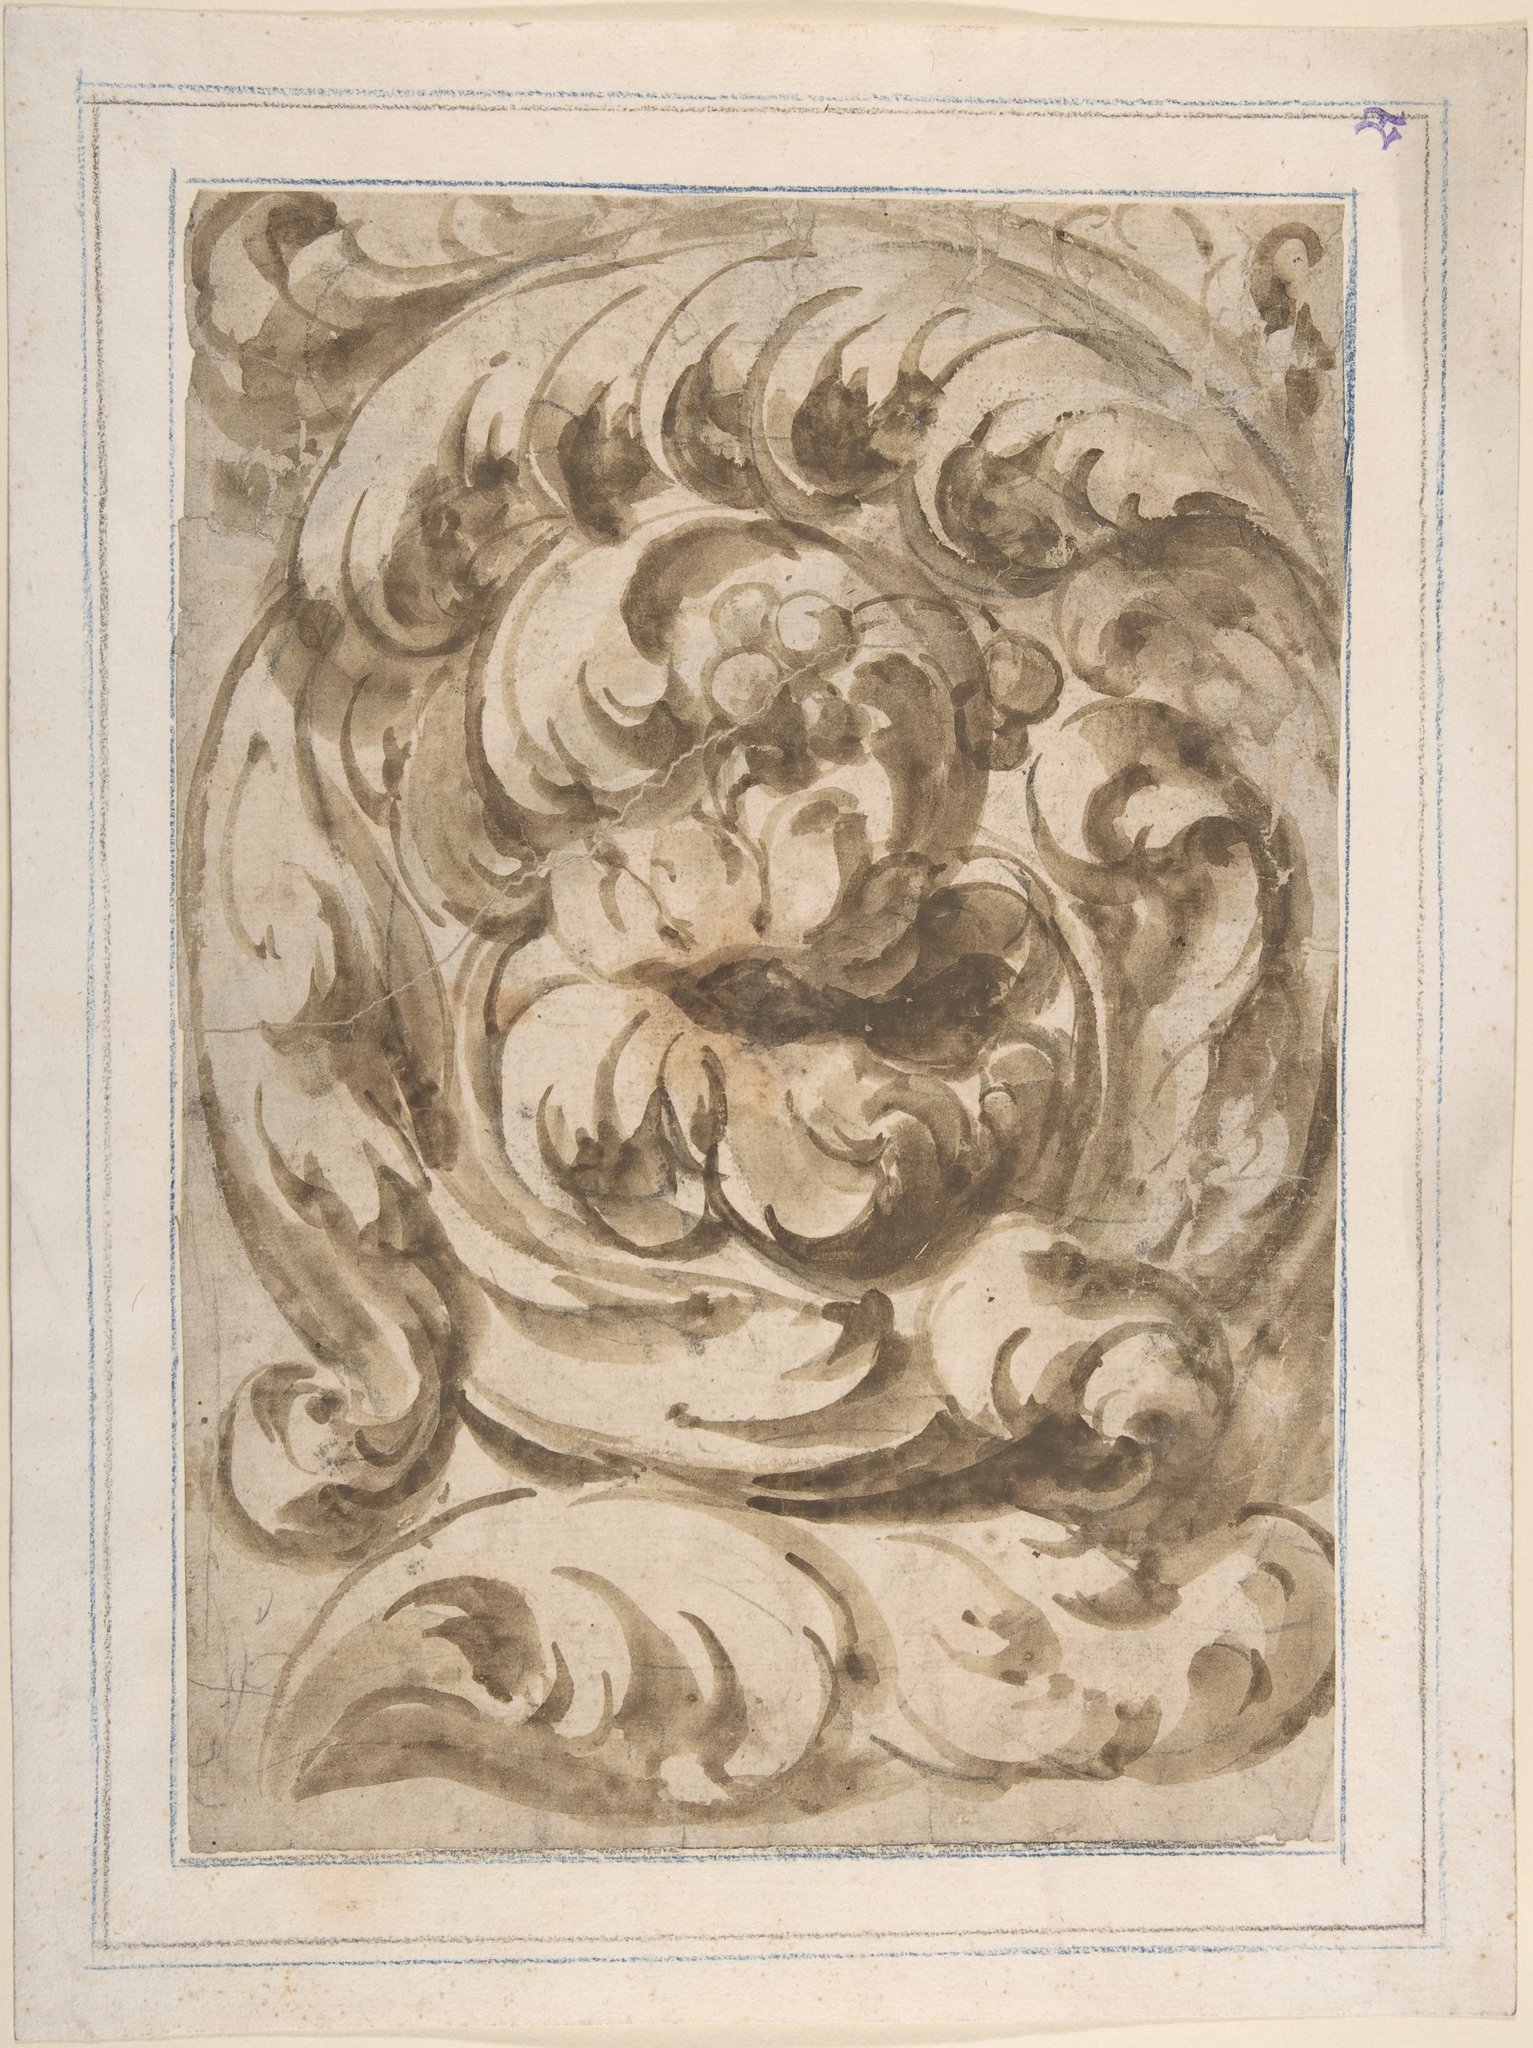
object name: drawing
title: Acanthus Scroll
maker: anonymous, italian, 17th century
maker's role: artist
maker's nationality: italian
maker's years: 1600-1700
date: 1601-1700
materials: chalk, graphite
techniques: brush, wash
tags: scrolls,acanthus